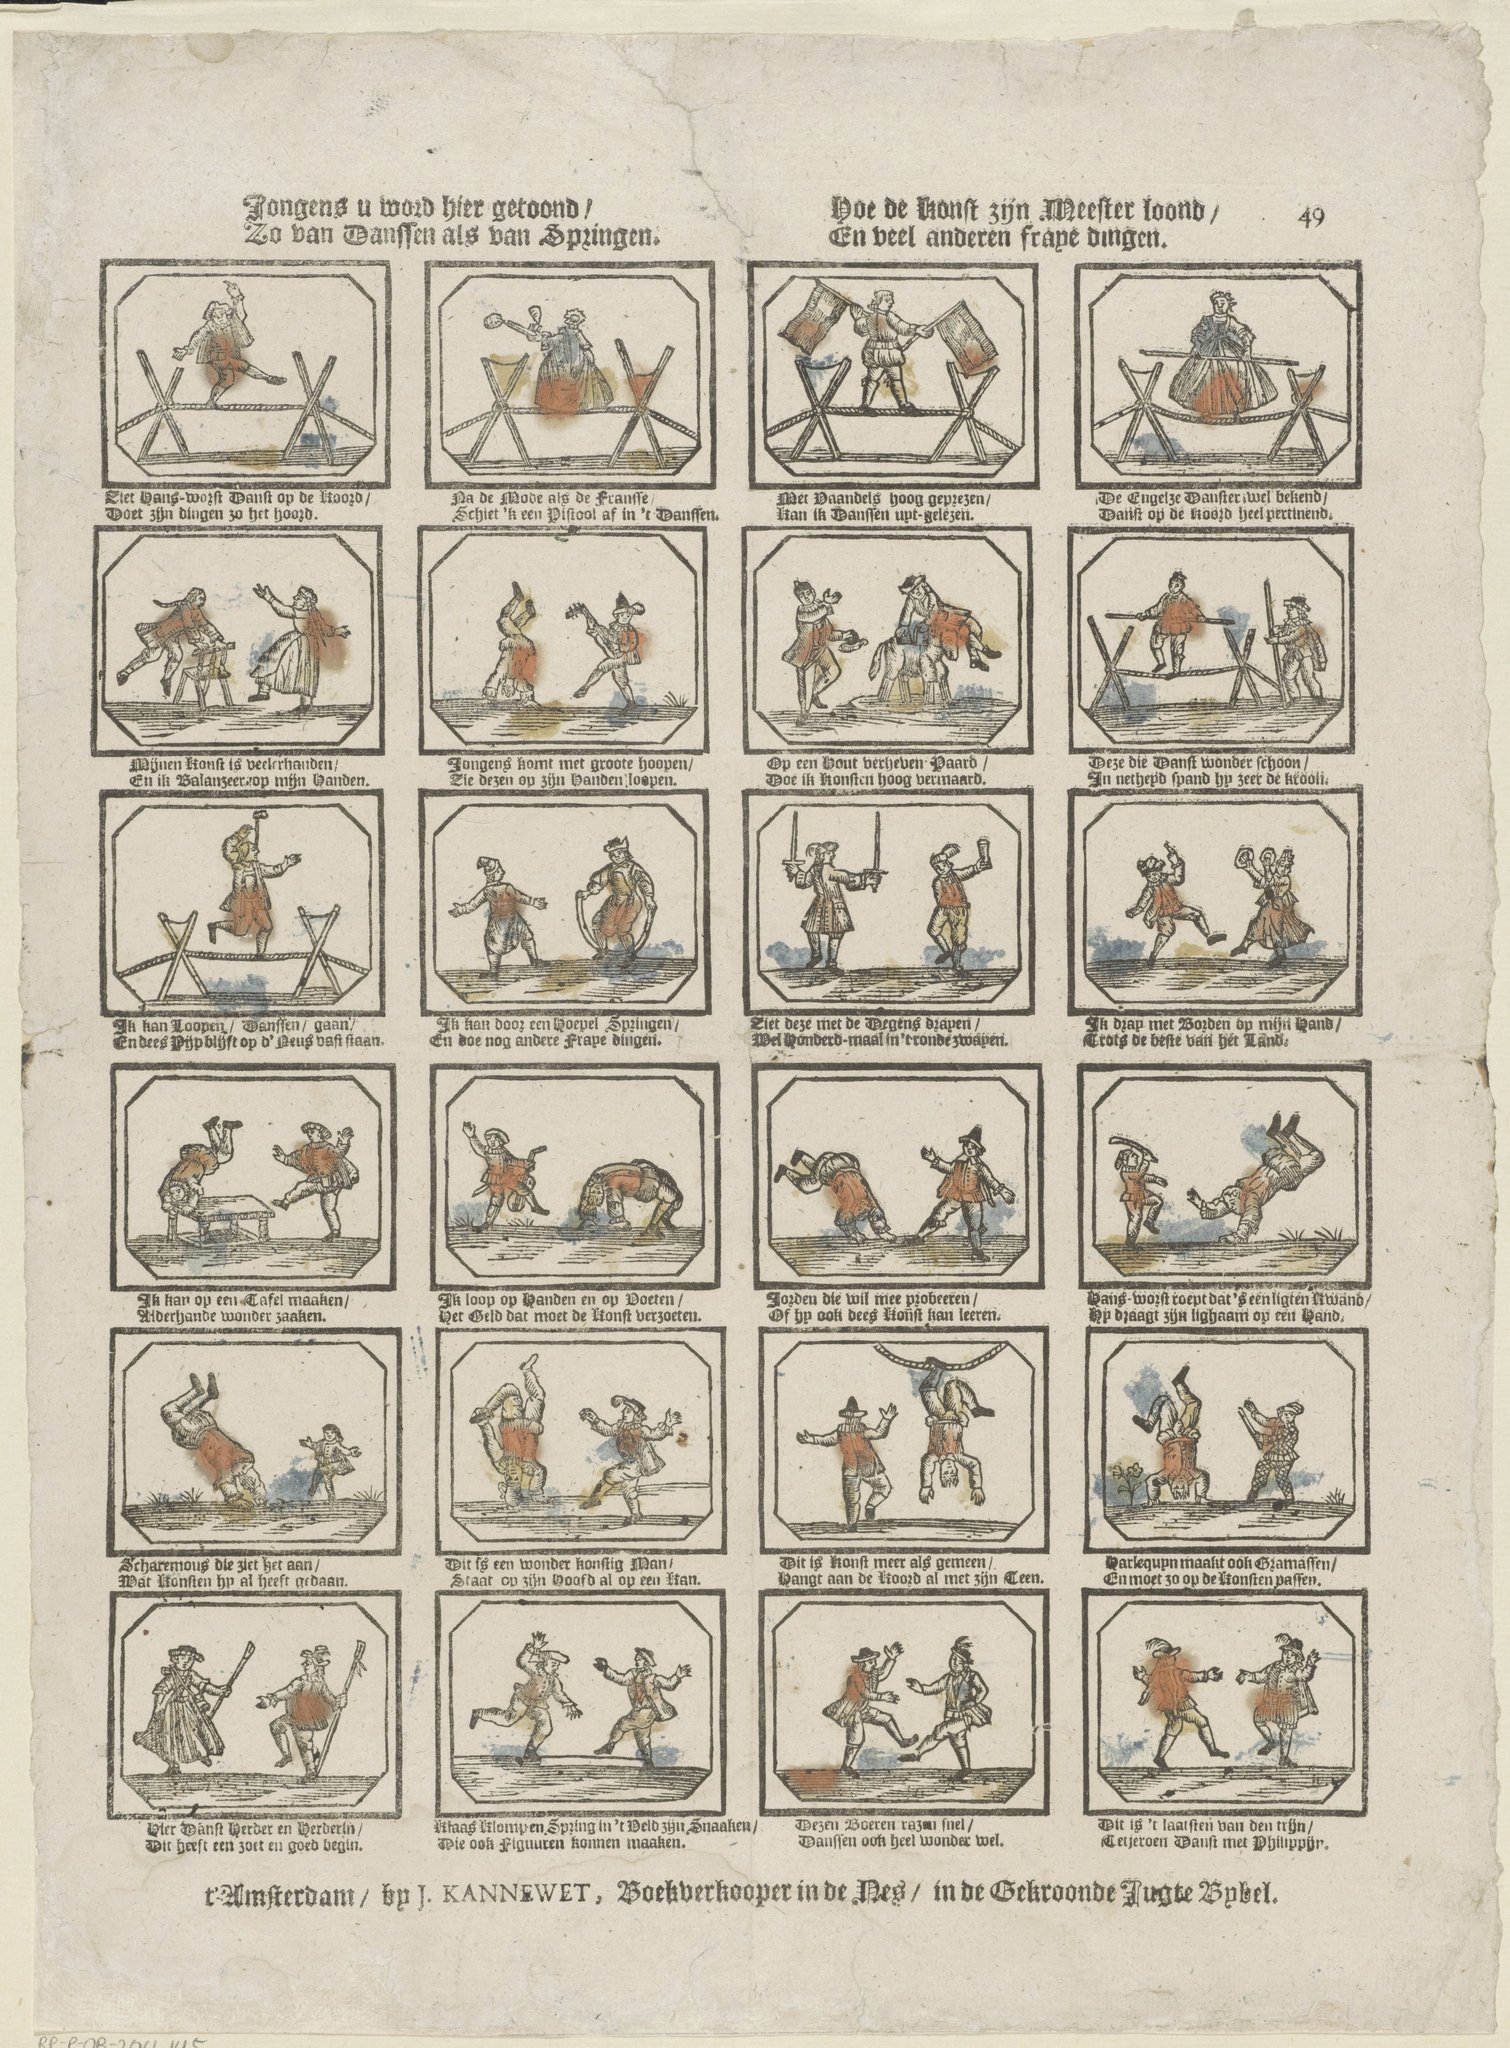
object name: popular print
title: Jongens u word hier getoond / Zo van danssen als van springen / Hoe de konst zijn meester toond / En veel anderen fraye dingen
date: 1725-1780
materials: paper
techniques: colour, letterpress printing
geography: amsterdam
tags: equilibrist, dancing, acrobat ~ circus, male dancer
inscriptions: collector's mark: Lugt 2760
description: Blad met 24 voorstellingen van acrobaten en dansers. Onder elke afbeelding een tweeregelig vers. Genummerd rechtsboven: 49.